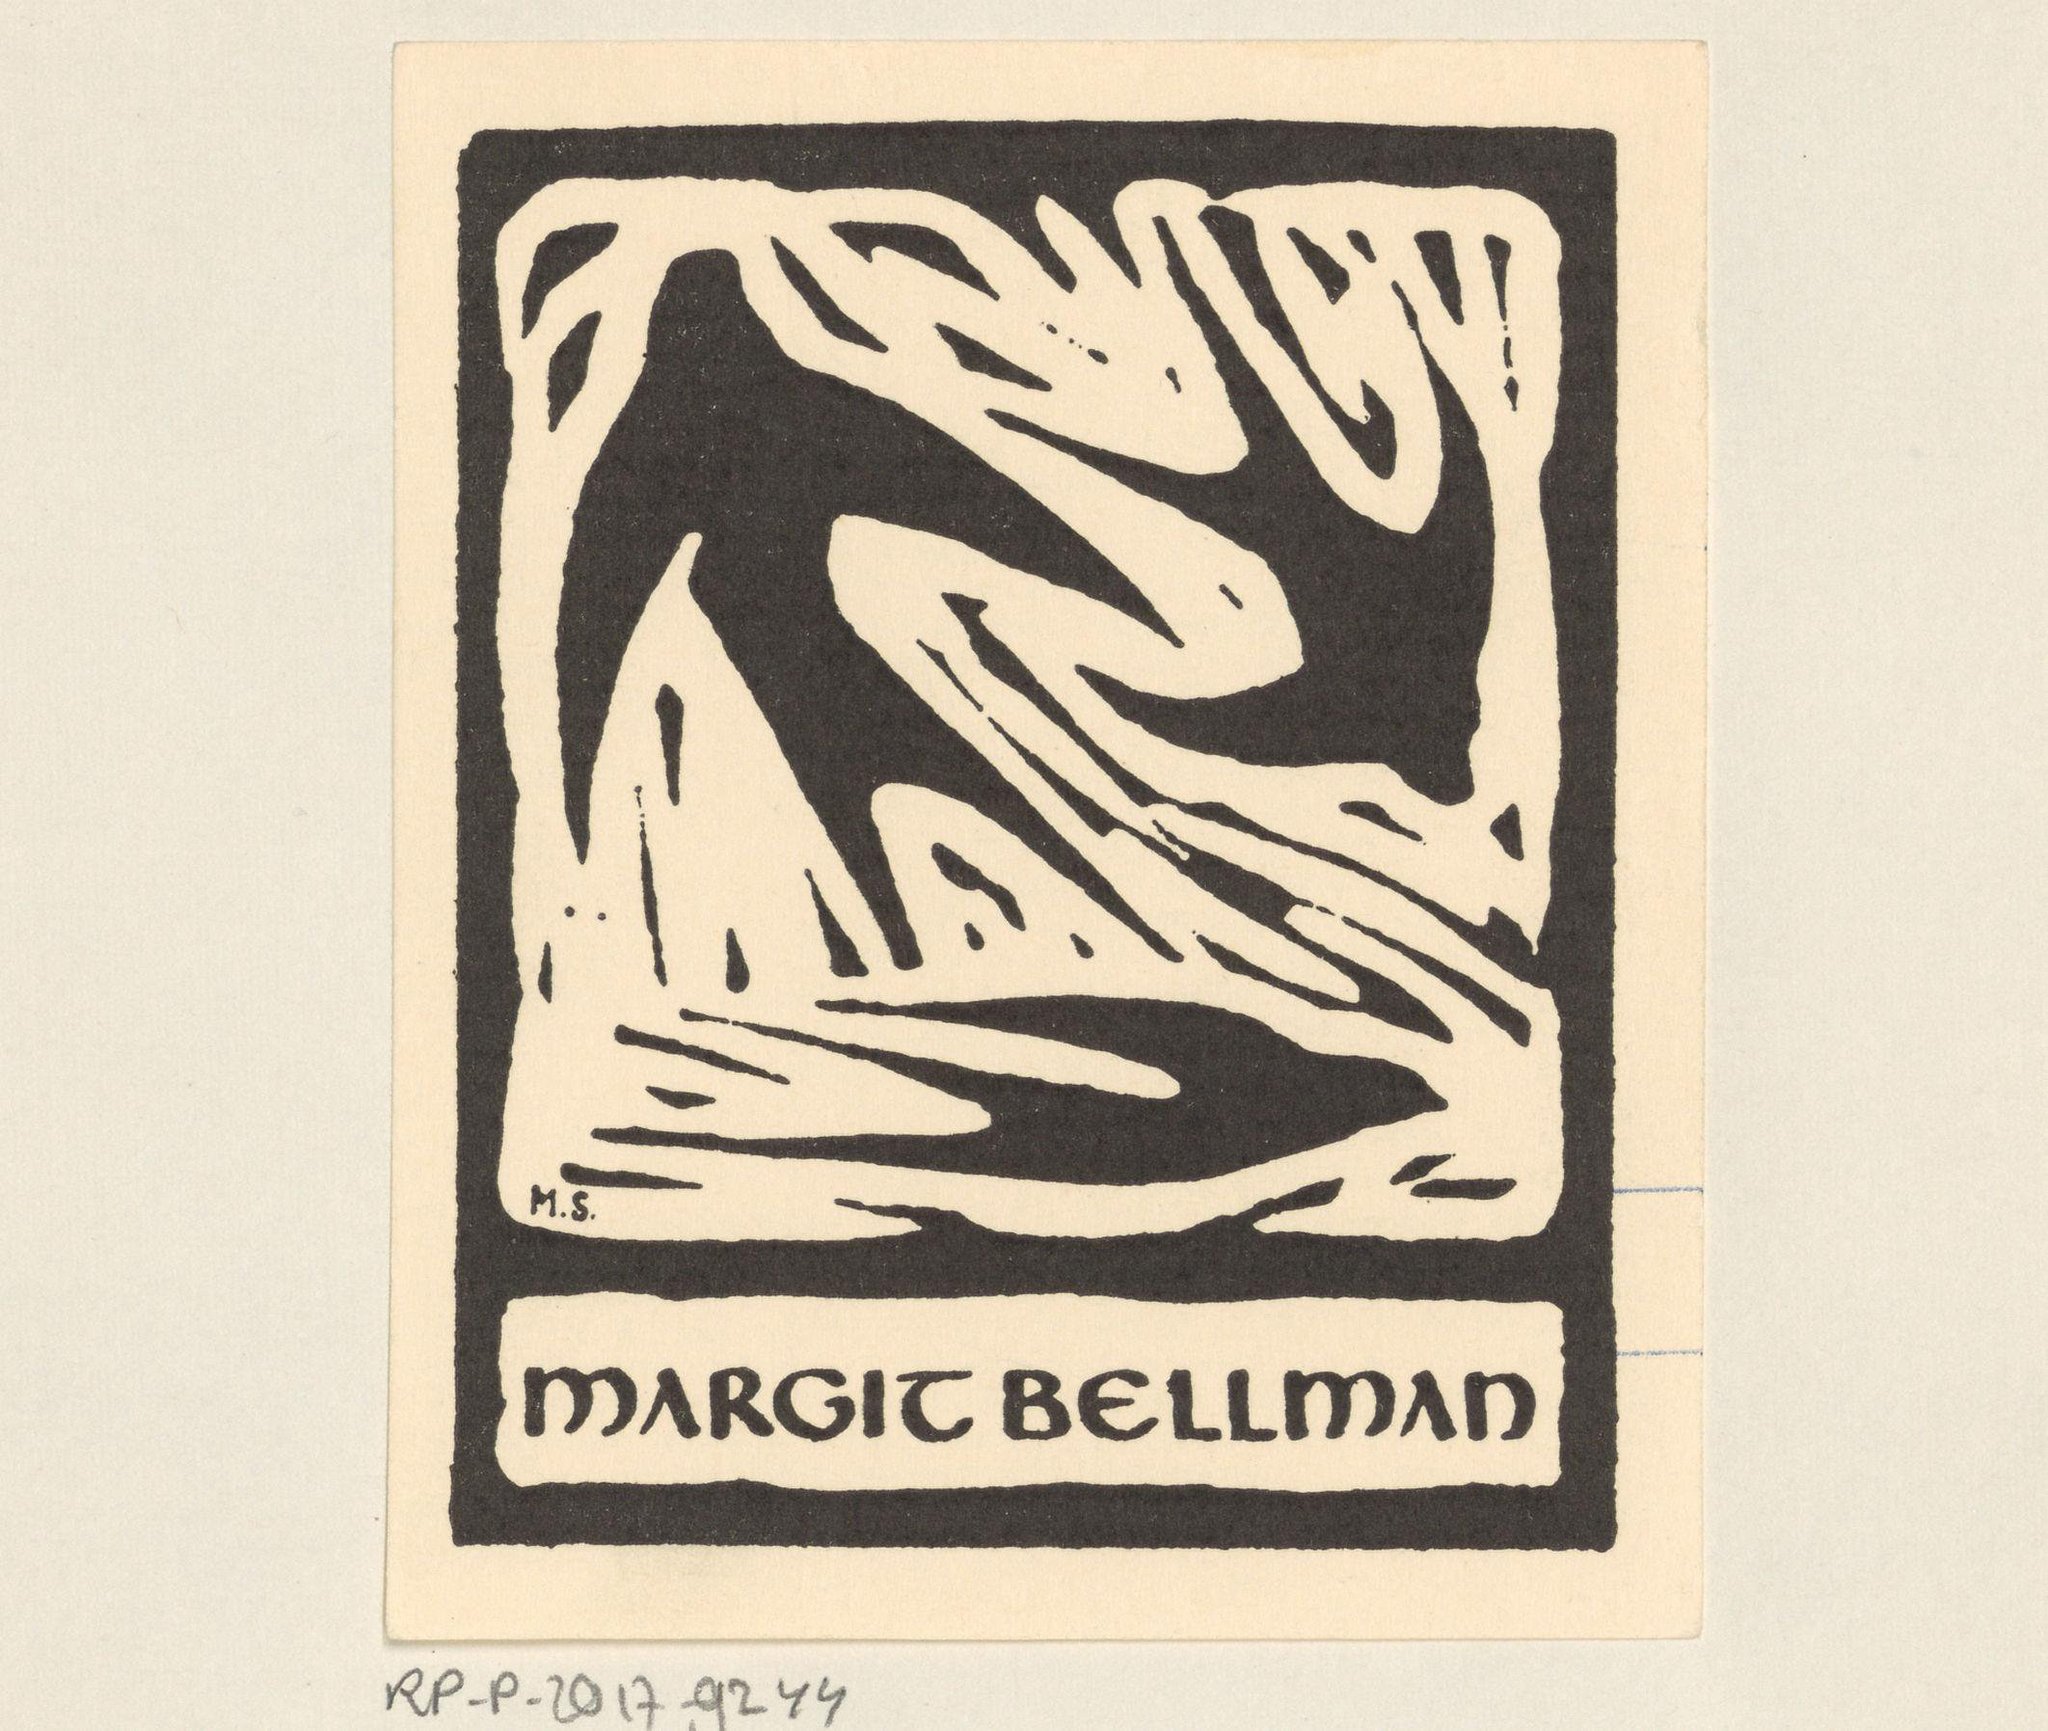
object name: bookplate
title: Ex libris van Margit Bellman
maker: Anonymous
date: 1900-1999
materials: paper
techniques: linocut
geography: sweden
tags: song-birds: swallow